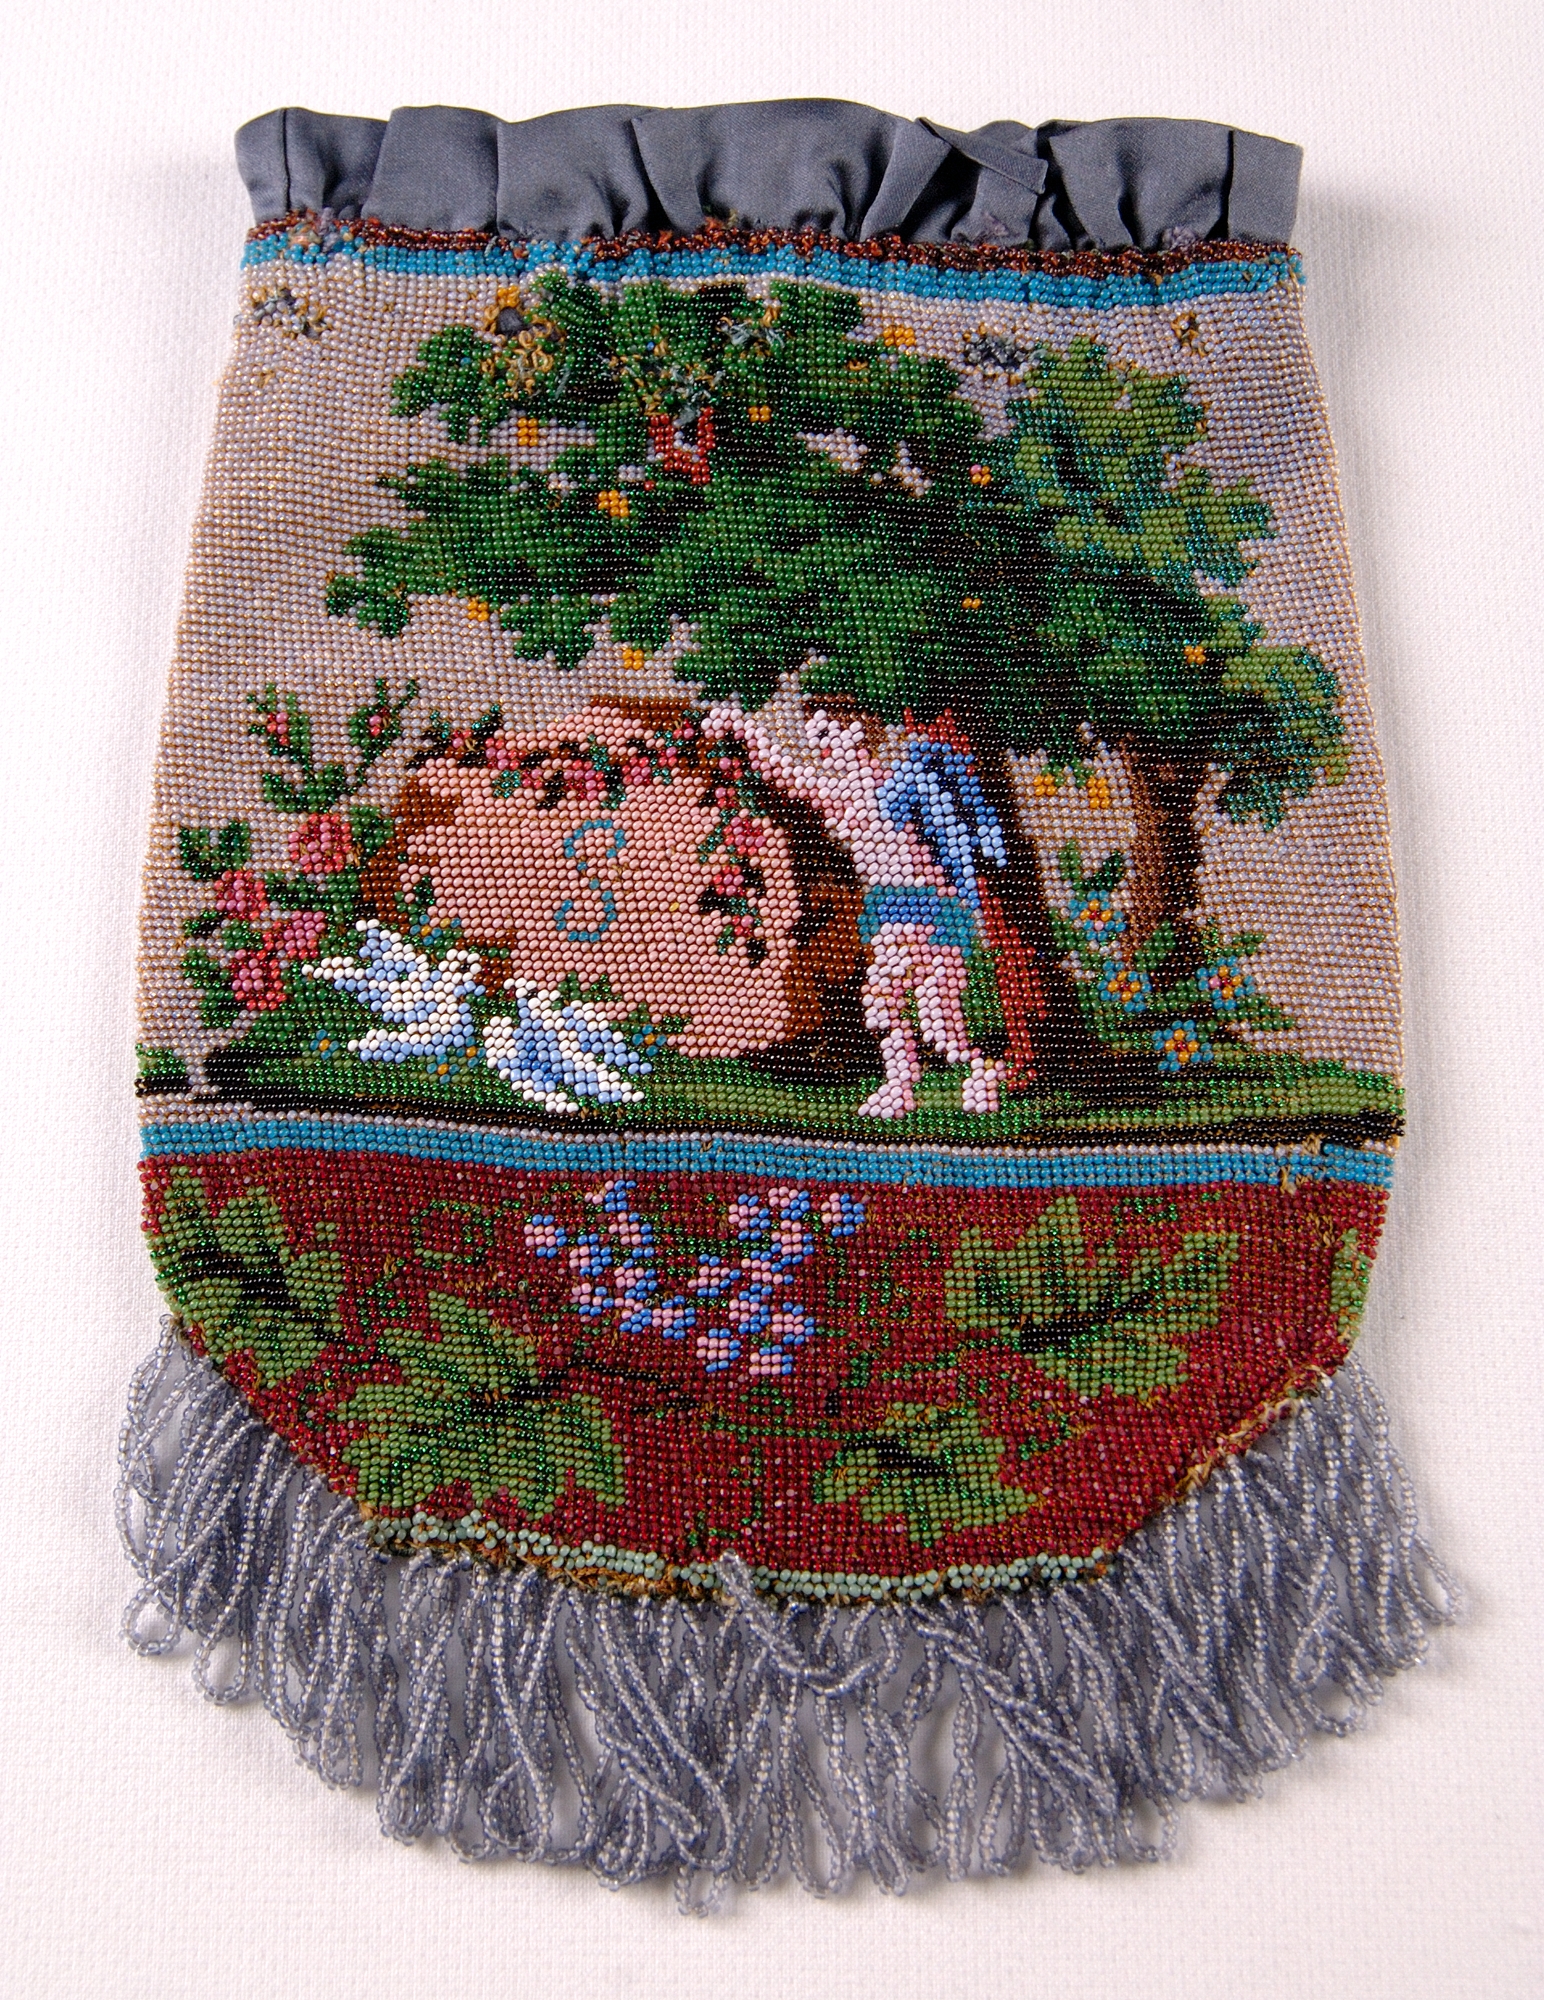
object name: pouch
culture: american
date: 1860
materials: glass, linen, silk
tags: cupid